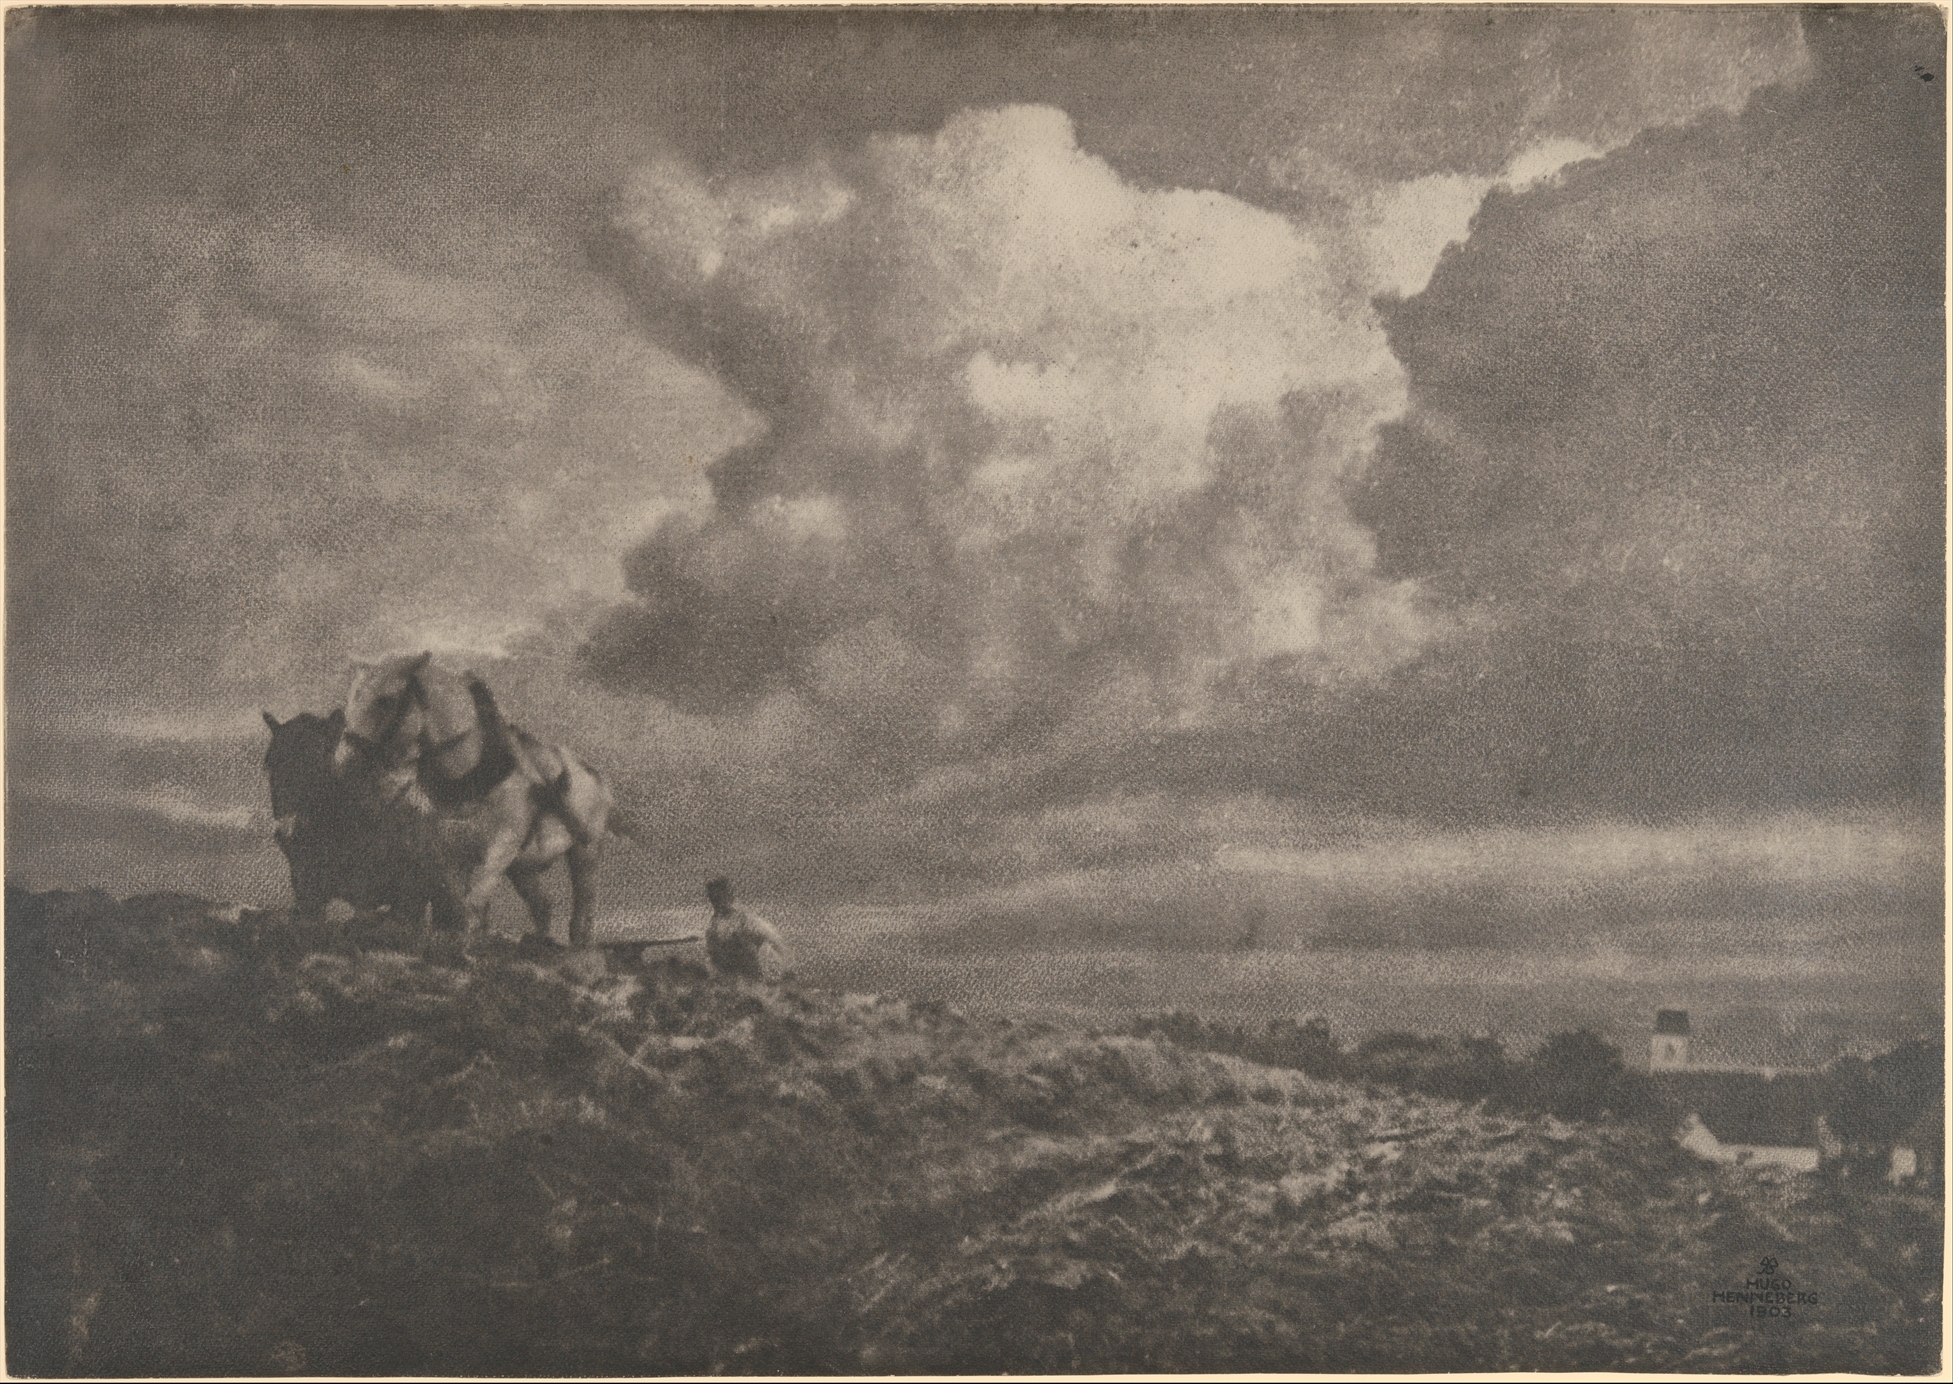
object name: photograph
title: Pflügen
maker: hugo henneberg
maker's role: fotograaf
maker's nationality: austrian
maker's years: 1863-1918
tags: men,horses,sky,clouds